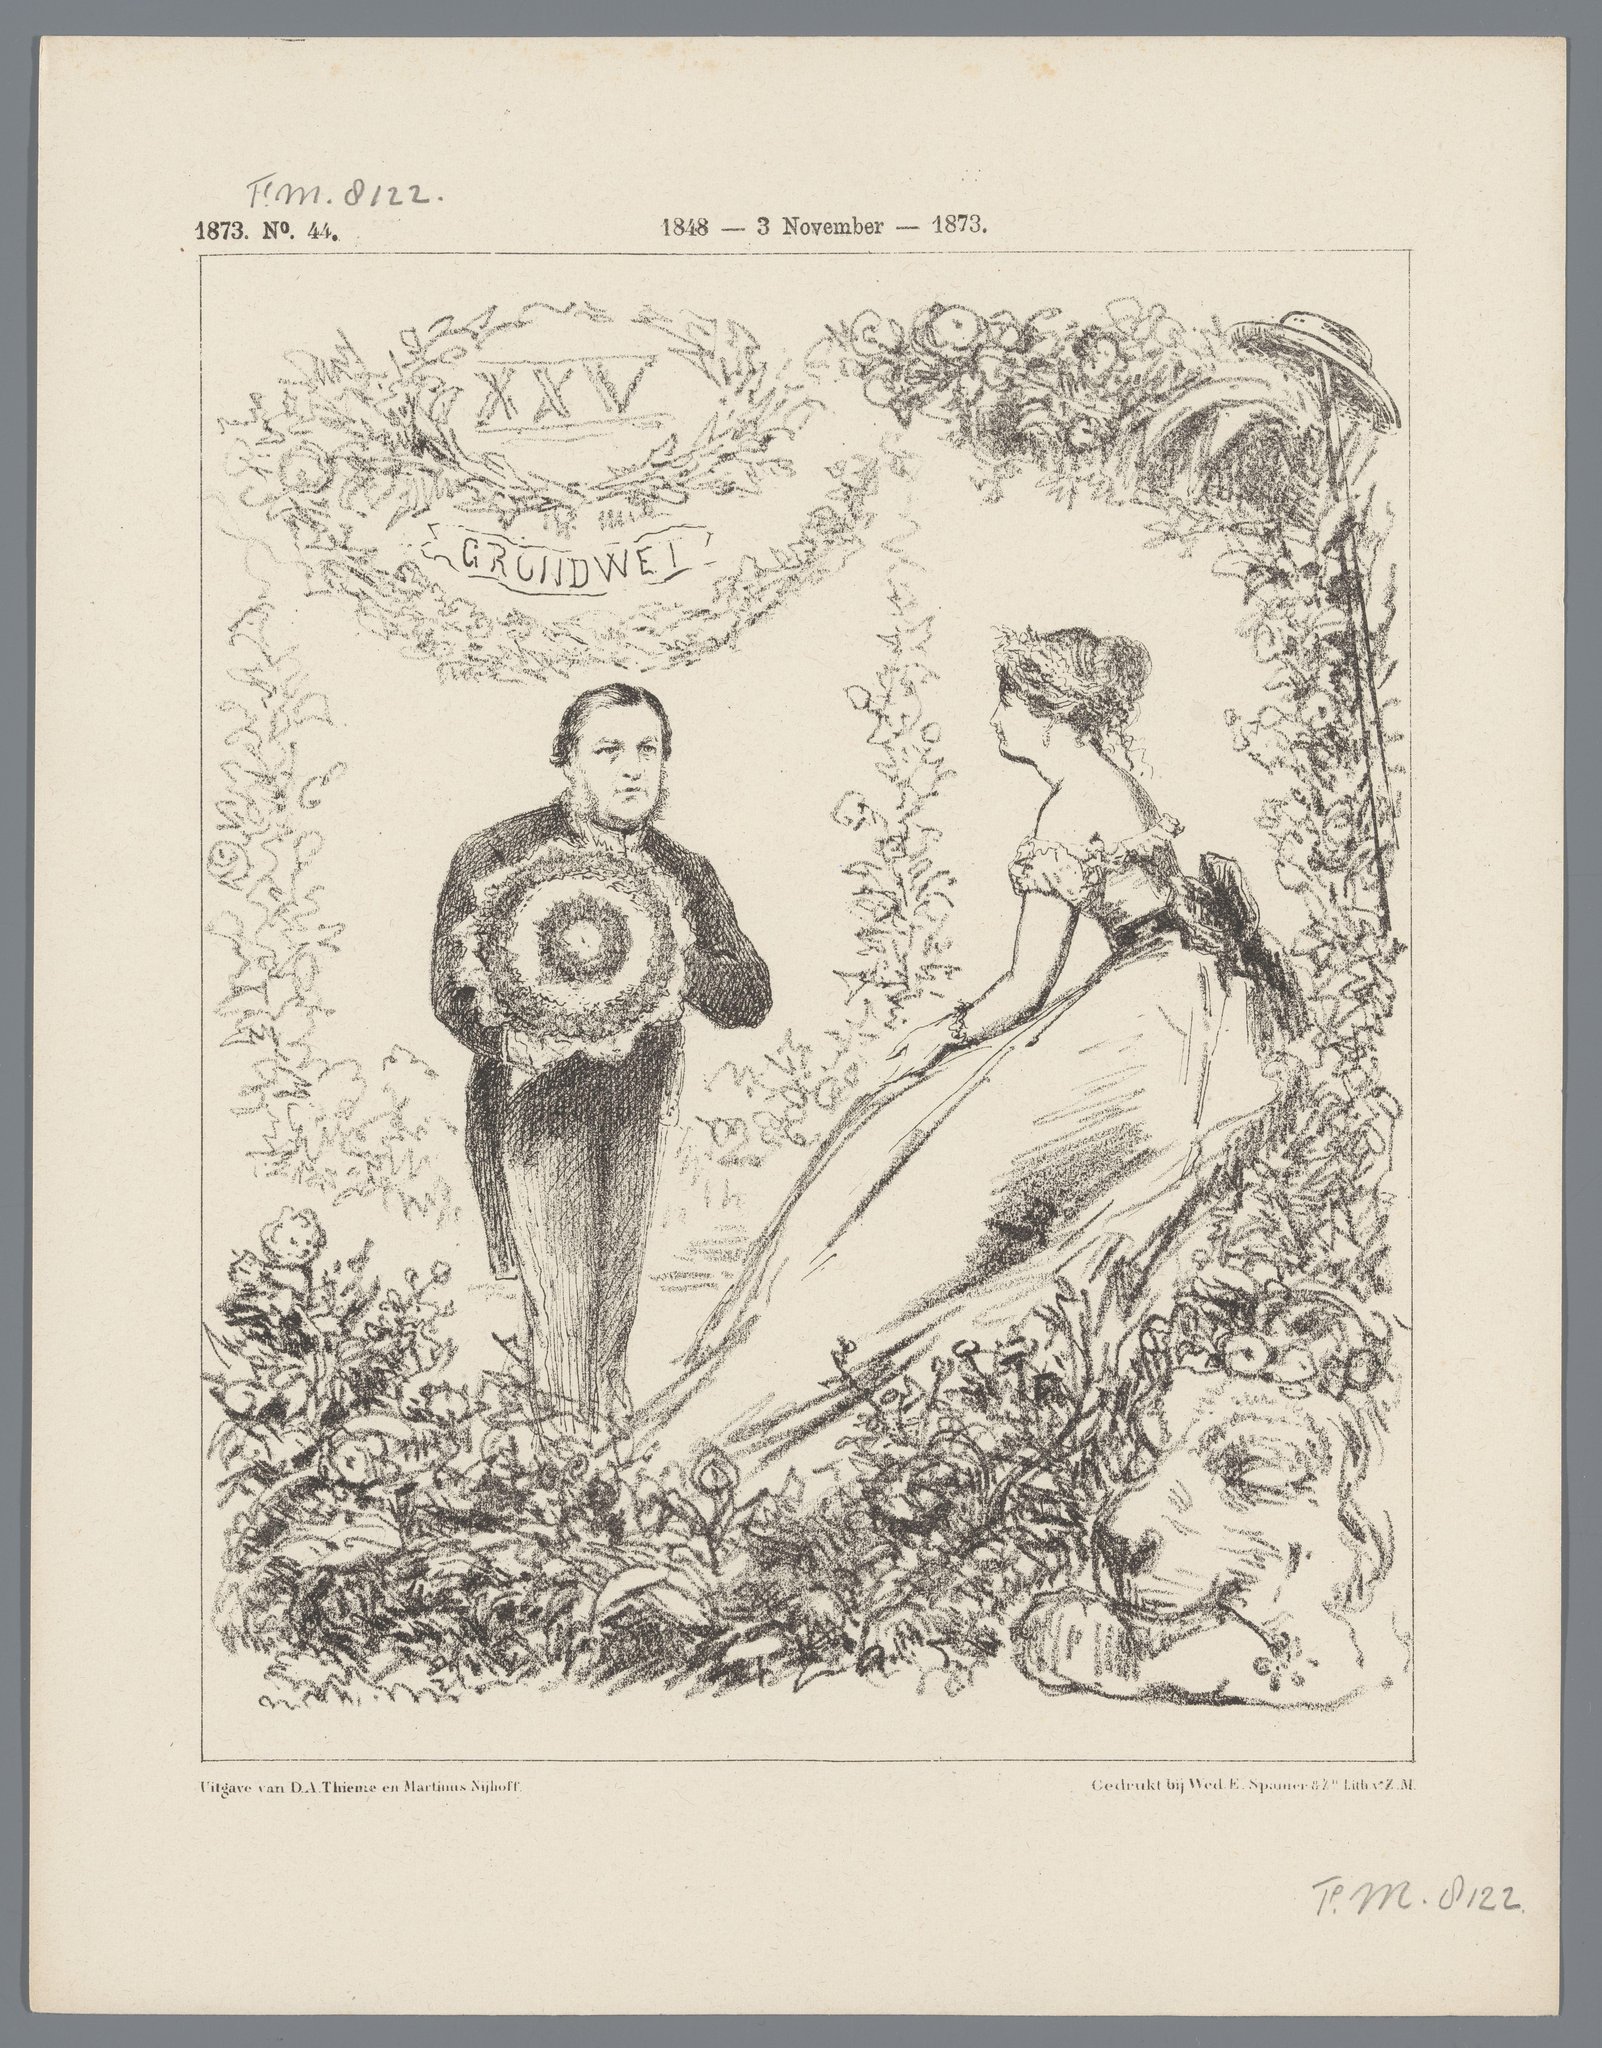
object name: print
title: 1848 - 3 November - 1873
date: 1873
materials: paper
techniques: lithograph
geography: the hague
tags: personifications of countries, nations, states, districts, etc.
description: Spotprent op het 25-jarig bestaan van de grondwet. Kamervoorzitter Dullert presenteert de Nederlandse Maagd een boeket. Plaat verschenen bij het weekblad De Nederlandsche Spectator, nr. 44, 1873.